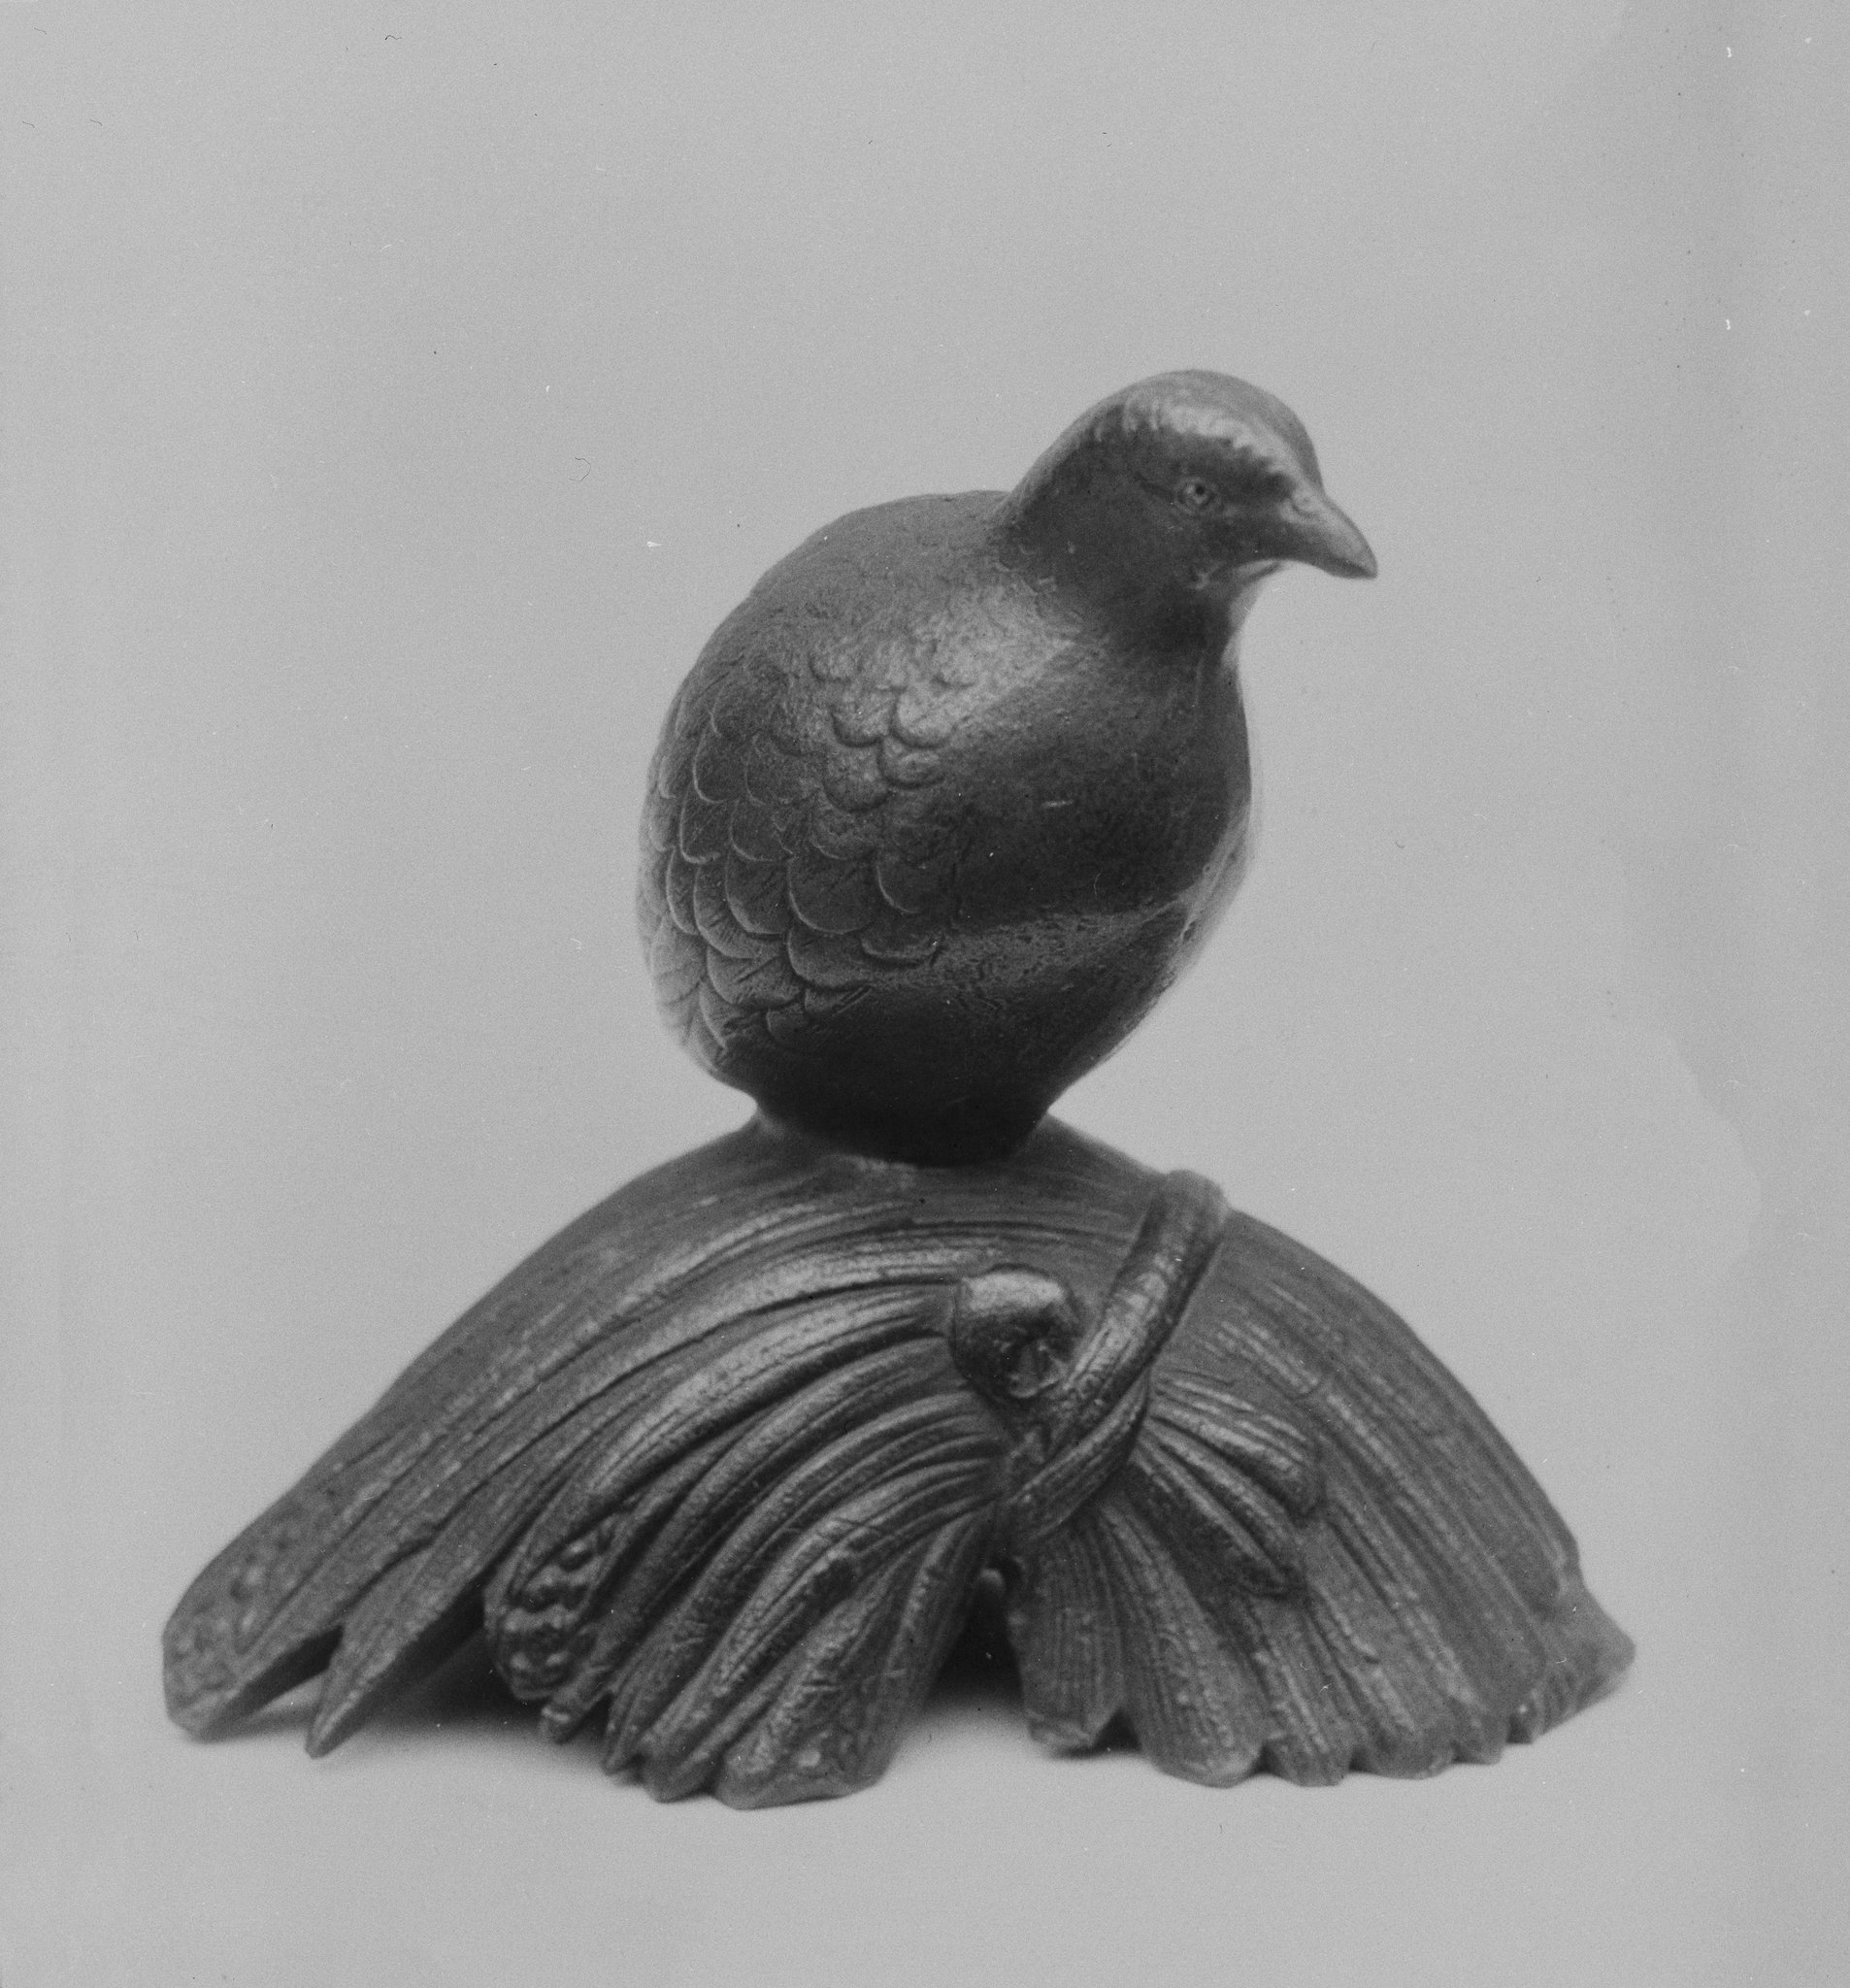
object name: figure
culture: japanese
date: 1700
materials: glaze, stoneware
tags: birds